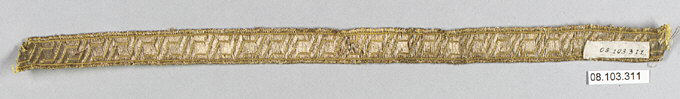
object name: galloon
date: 1601-1800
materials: silk